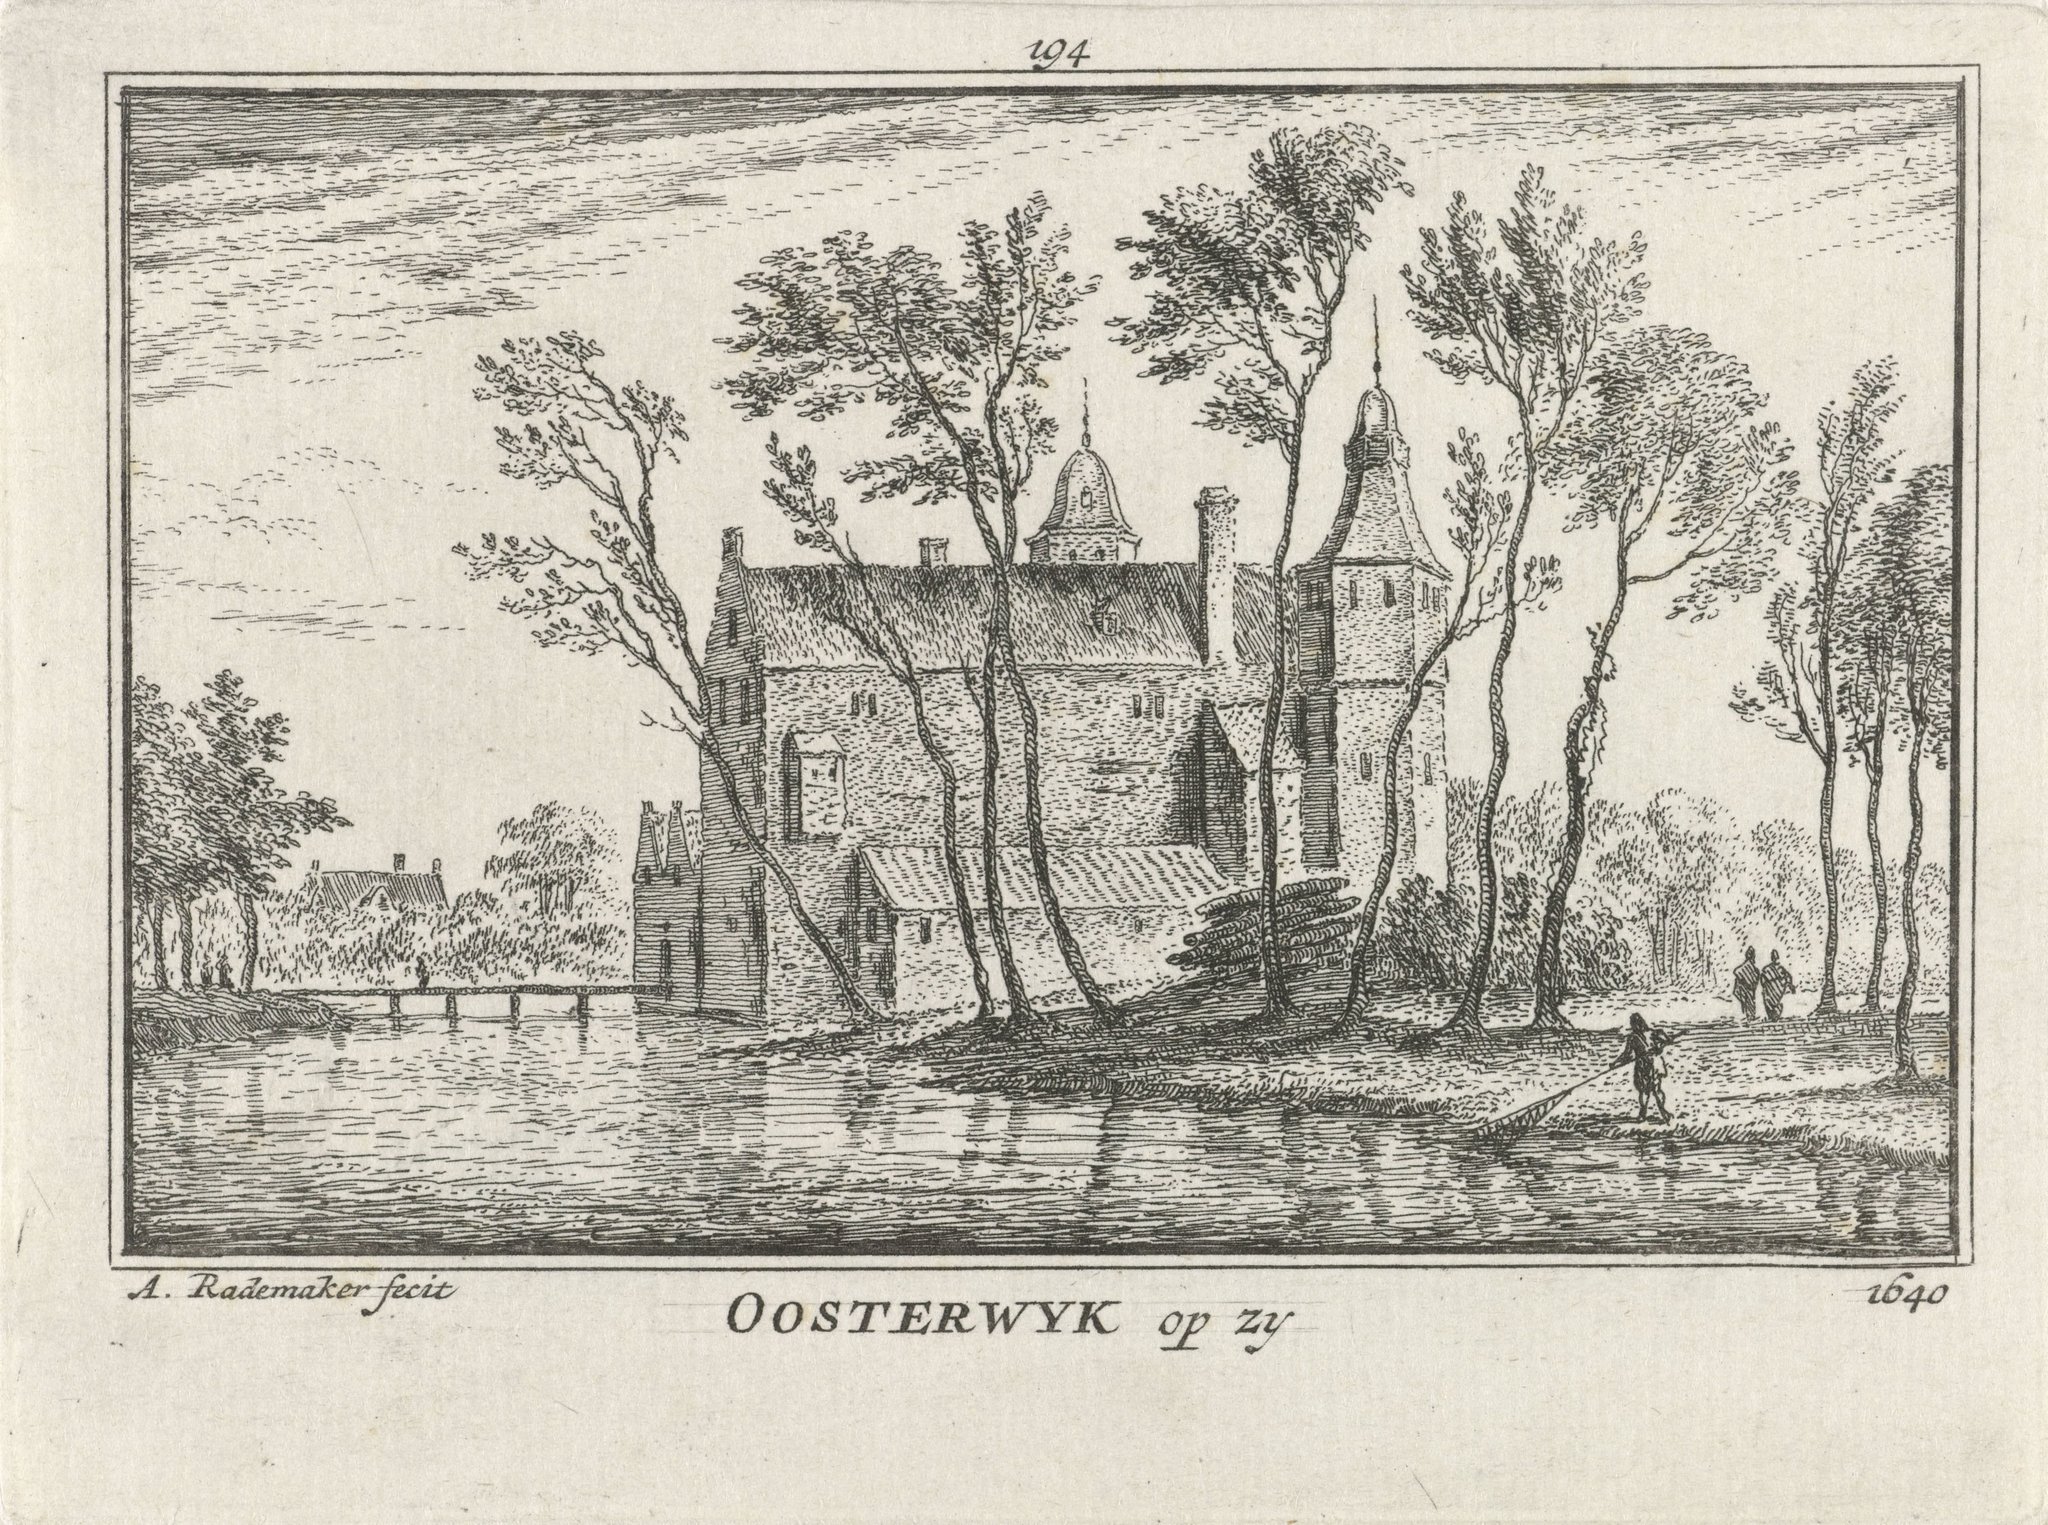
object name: book illustration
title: Gezicht op Huis Oosterwijk, 1640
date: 1727-1733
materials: paper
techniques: etching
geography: amsterdam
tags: castle, fisherman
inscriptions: collector's mark: Lugt 2228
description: Illustratie uit: Abraham Rademaker, Matthaeus Brouërius van Niedek, Isaac Le Long, Kabinet van Nederlandsche en Kleefsche outheden en (...) voorname stads- en landgebouwen, Willem Barents en Antoni Schoonenburg: Amsterdam, 1727-1733, ill. nr. 194.